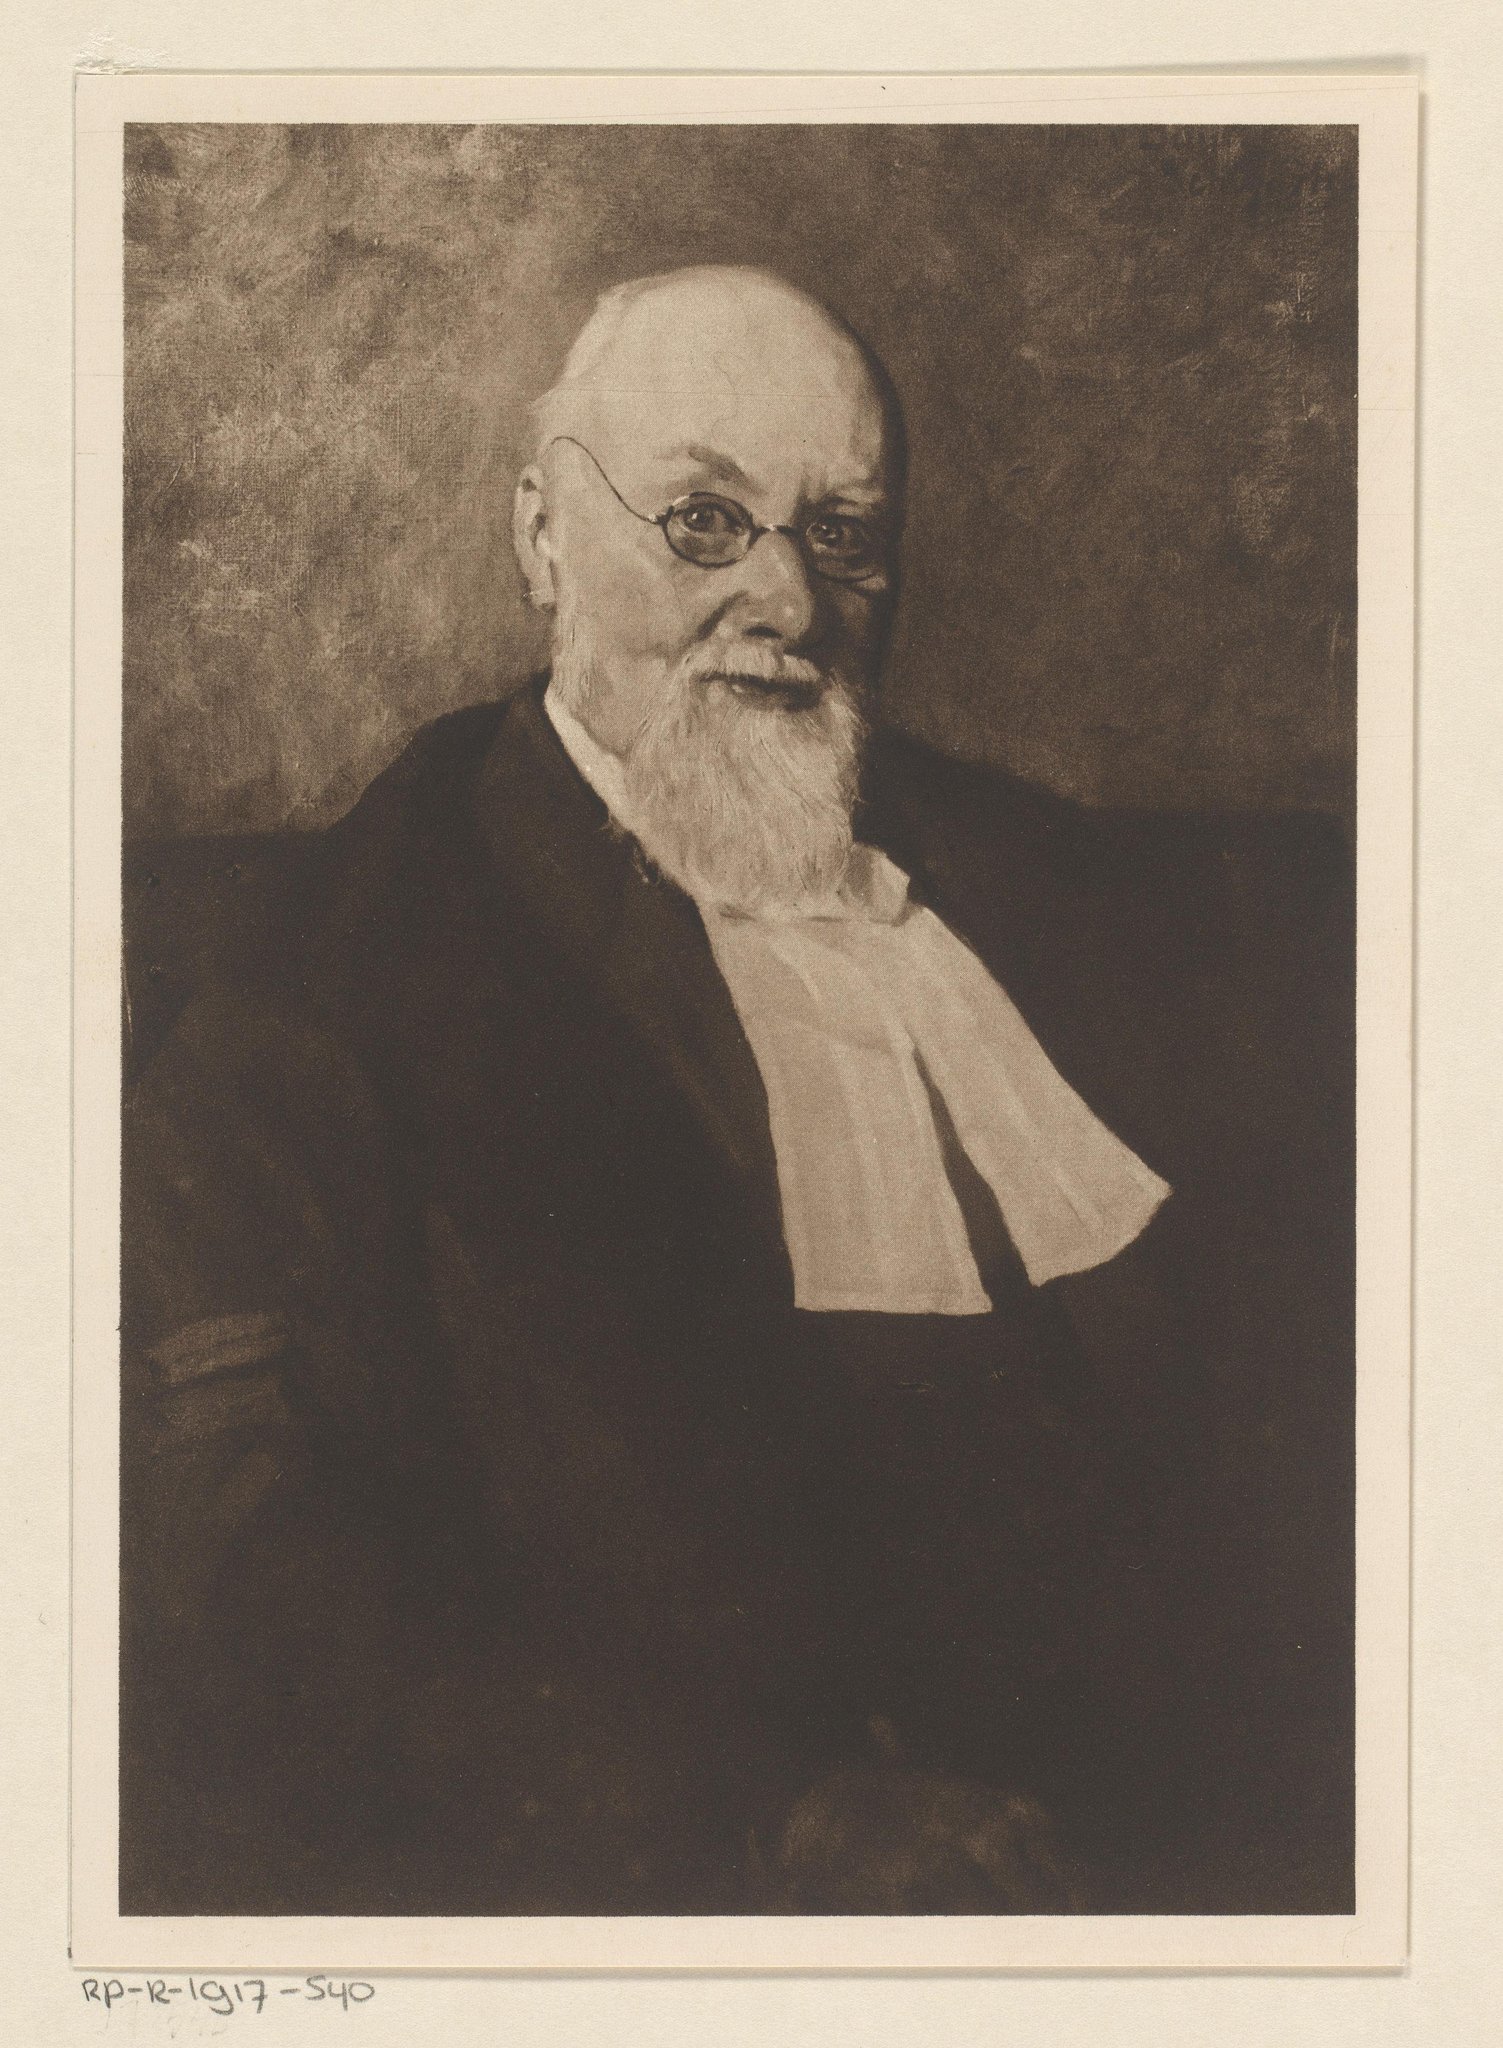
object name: reproduction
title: Portret van Jan te Winkel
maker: Anonymous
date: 1917-1950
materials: paper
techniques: rotogravure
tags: amsterdam, historical persons, portrait of a writer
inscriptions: collector's mark: Lugt 2228